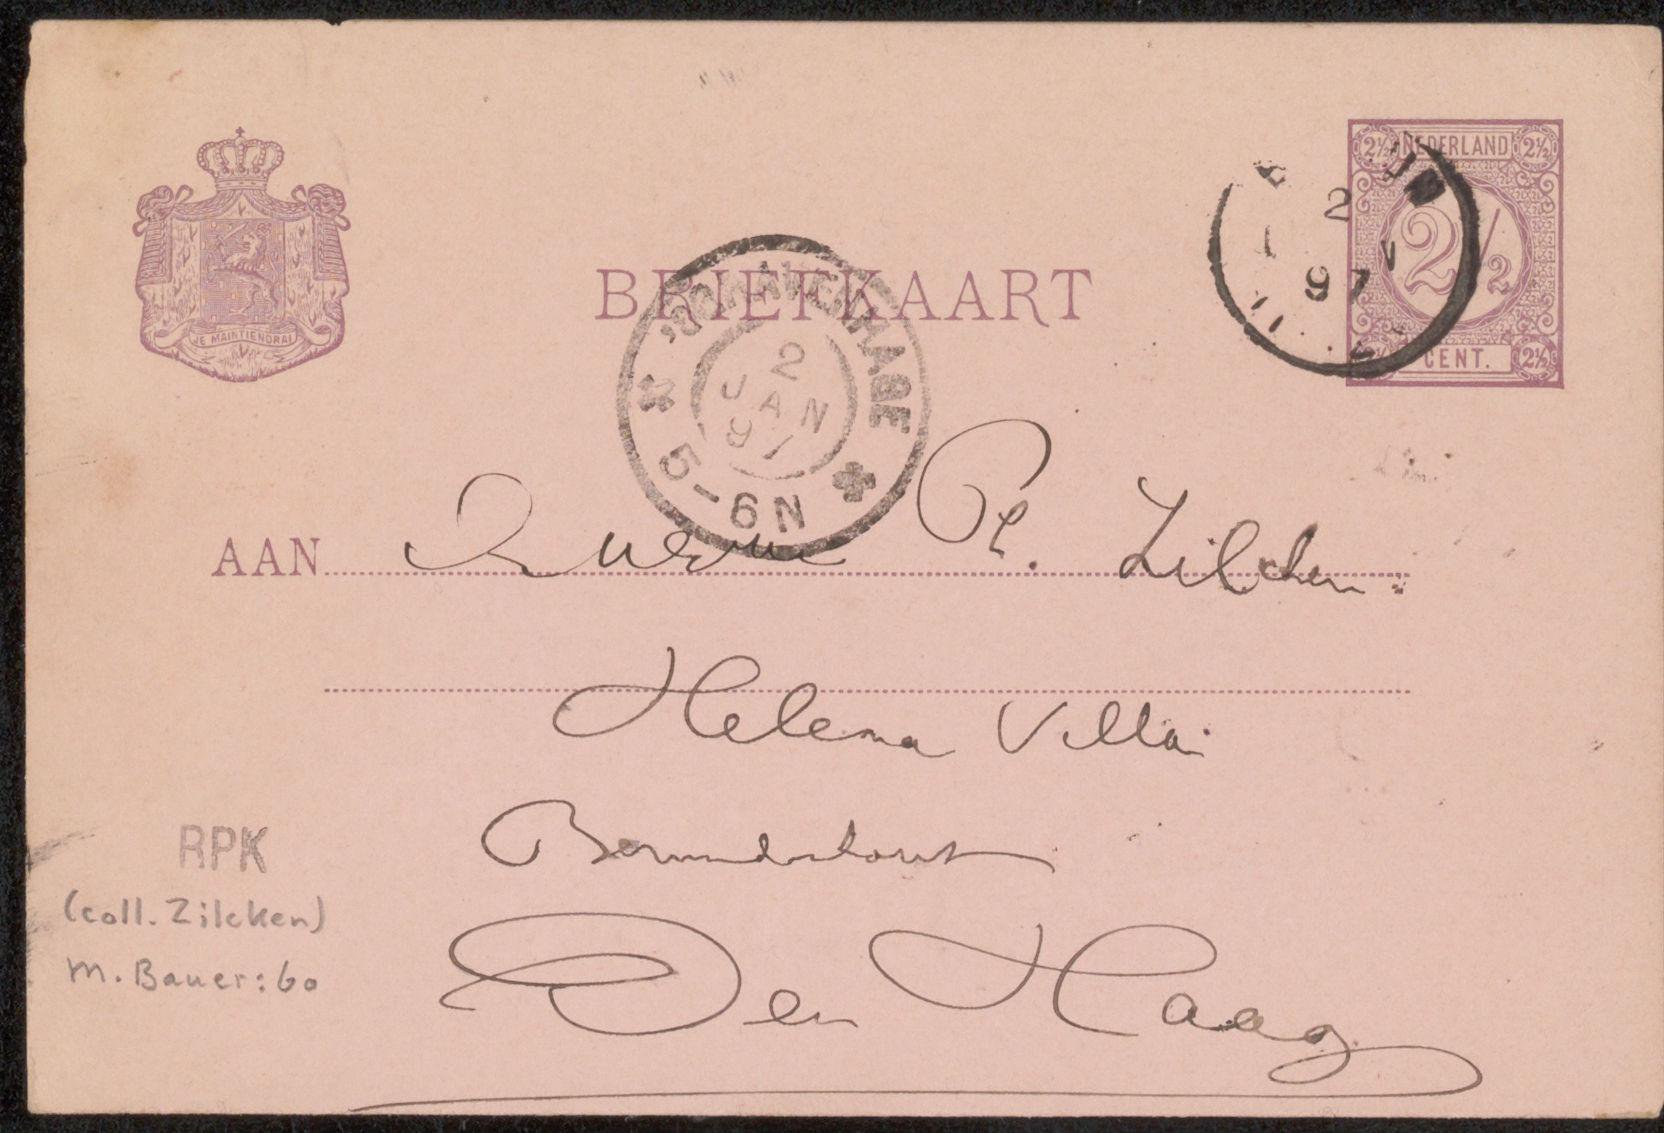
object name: postcard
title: Briefkaart aan Philip Zilcken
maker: marius bauer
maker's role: draughtsman, print maker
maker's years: 1867-1932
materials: cardboard, ink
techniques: pen, writing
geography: bussum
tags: painter, philip zilcken, venice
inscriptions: collector's mark: ‘RPK’